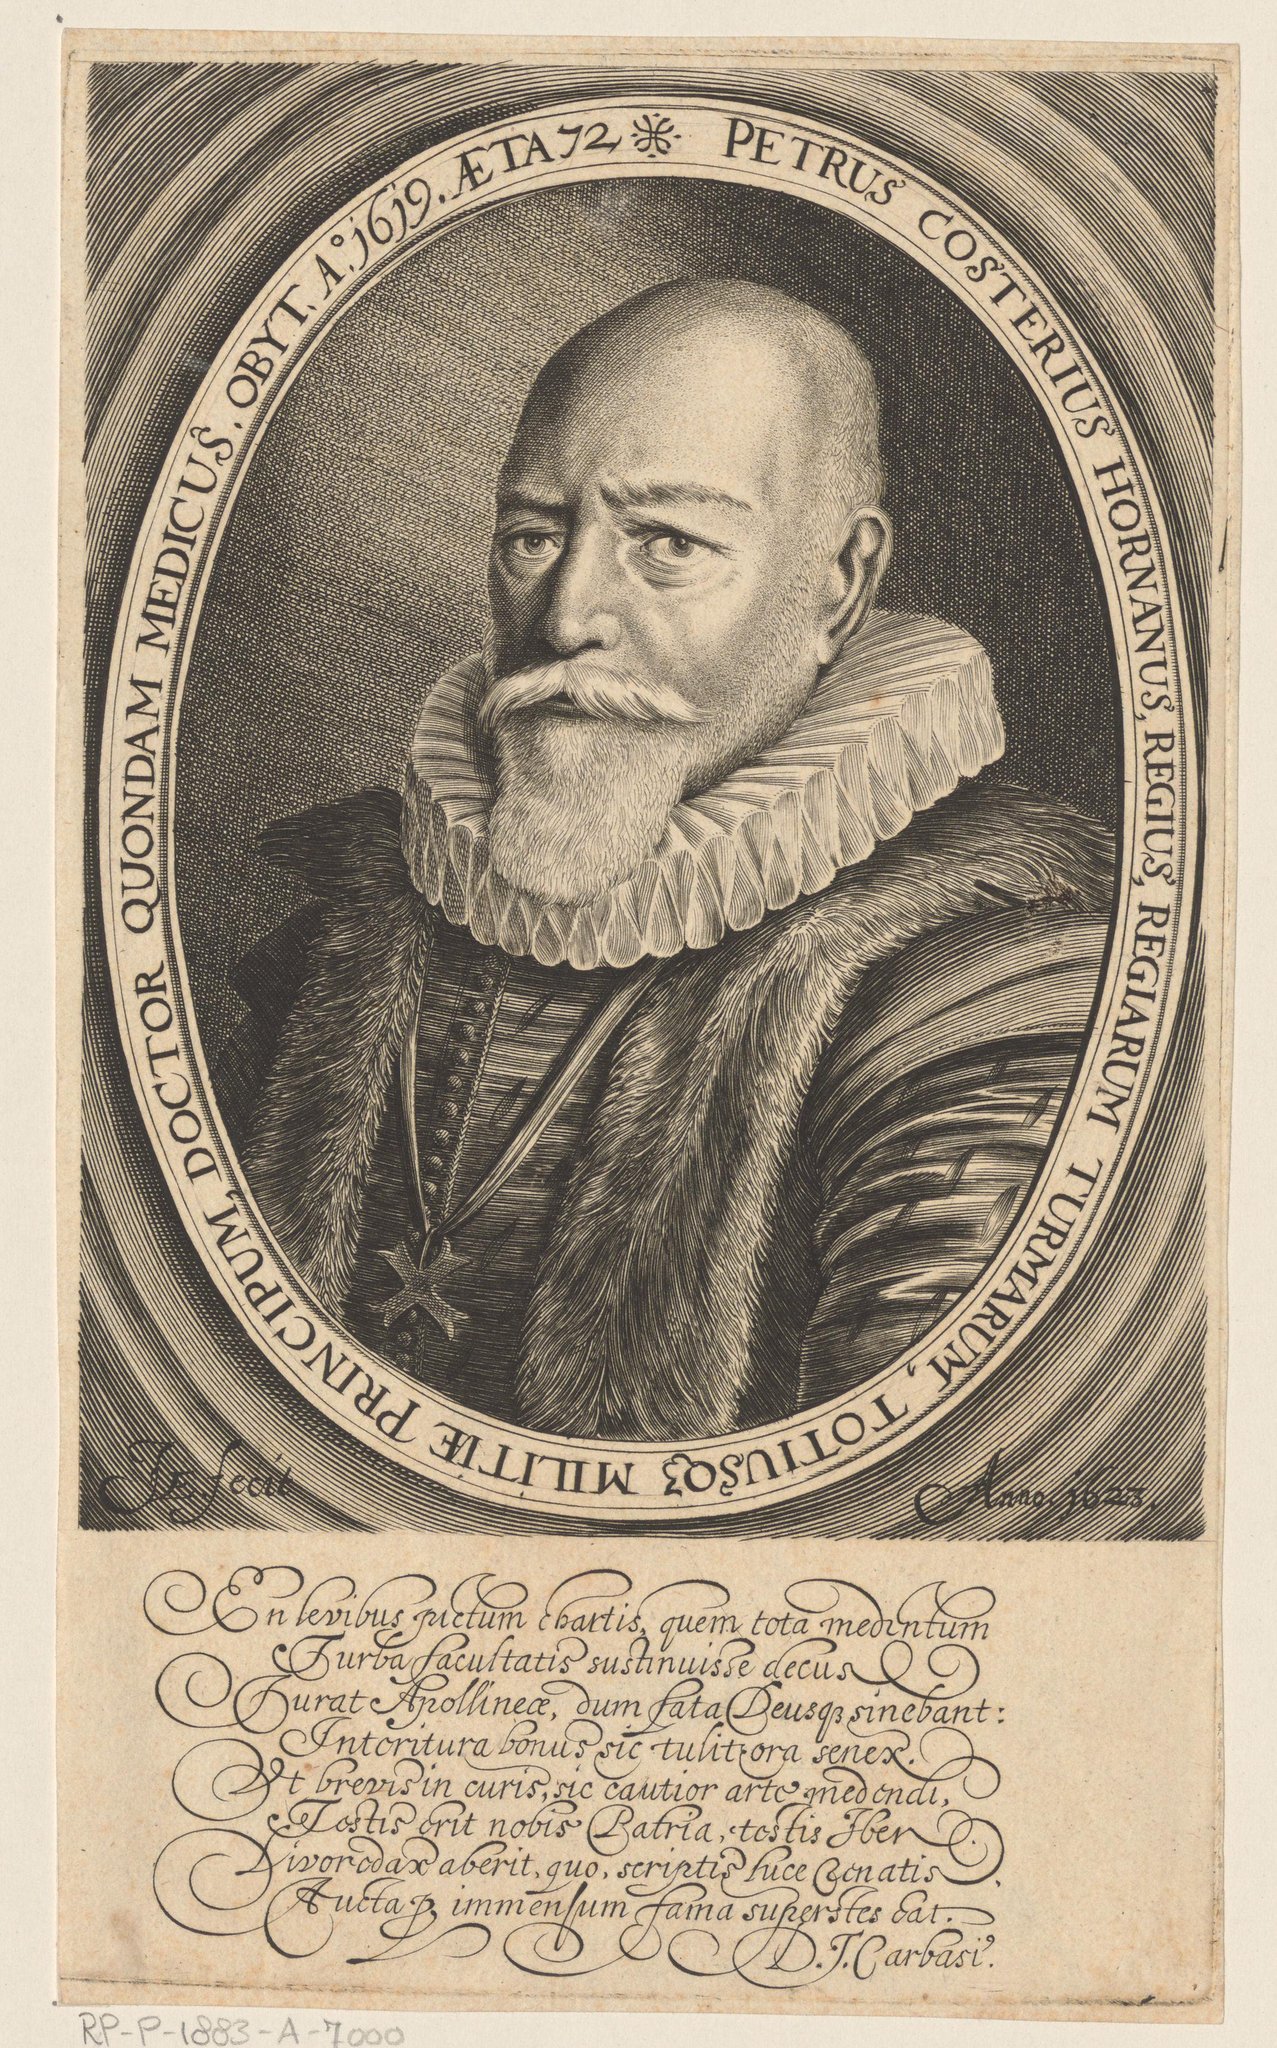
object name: print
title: Portret van Petrus Costerius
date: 1623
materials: paper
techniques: engraving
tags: historical persons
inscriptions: collector's mark: Lugt 2228, stamp: ‘Dubbel’